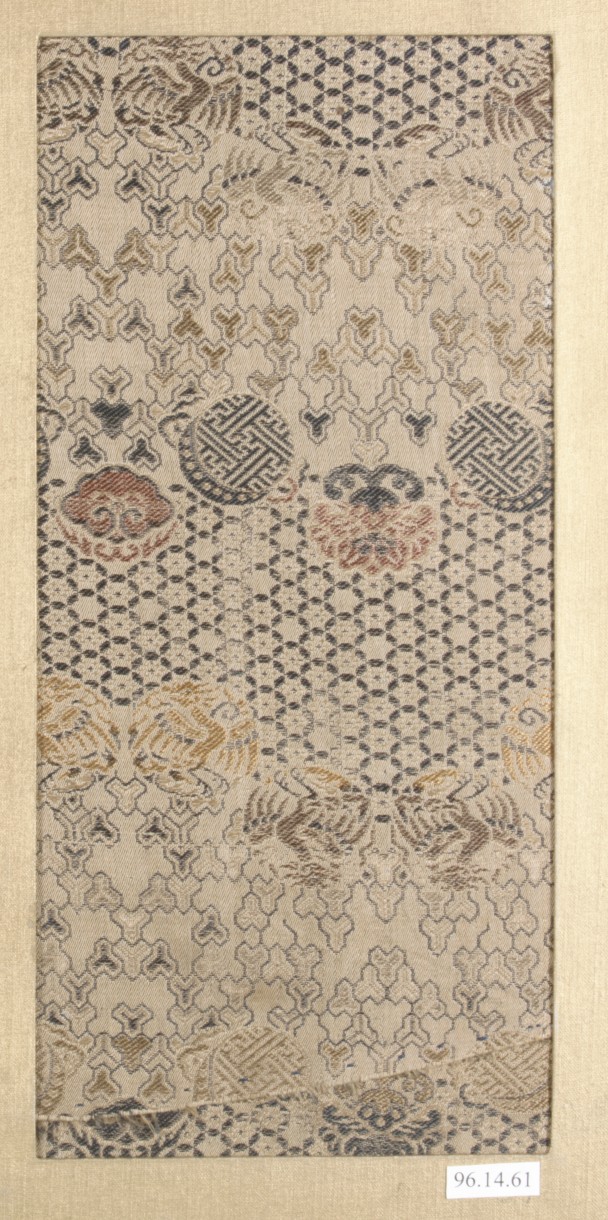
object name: piece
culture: japanese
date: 1701-1800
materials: silk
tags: birds